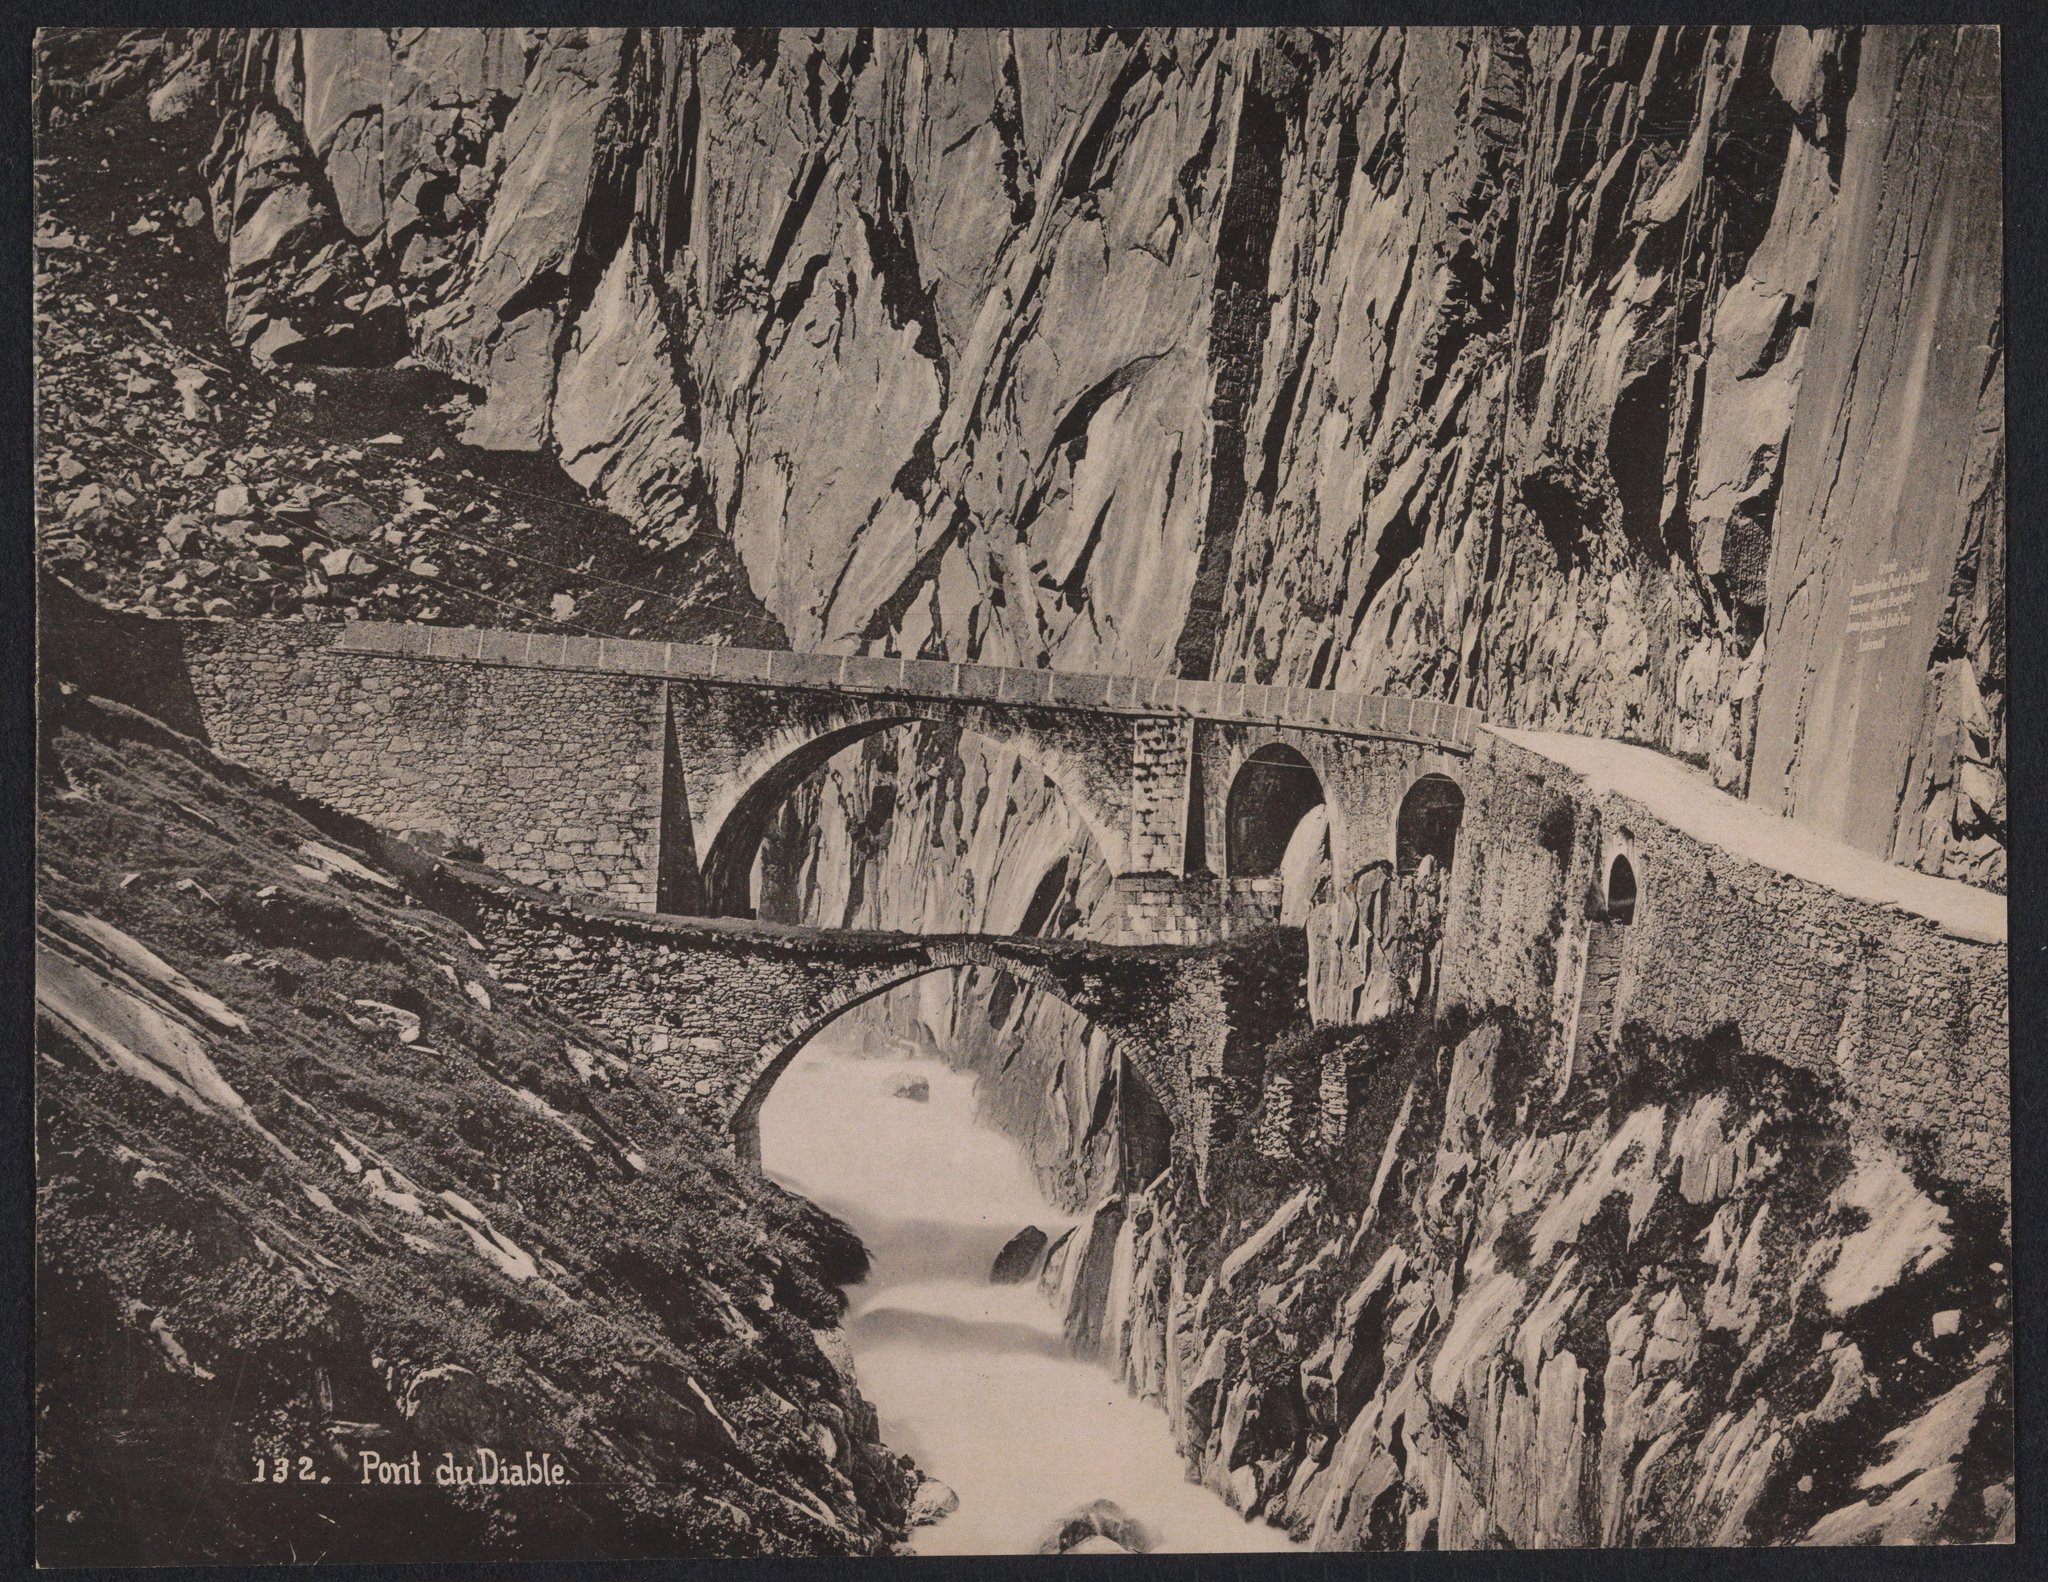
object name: photomechanical print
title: Gezicht op de Teufelsbrücke over de Schöllenenkloof nabij de Gotthardpas, Zwitserland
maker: Anonymous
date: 1880-1985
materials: cardboard, paper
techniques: photograph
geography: schöllenenkloof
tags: ravine, chasm, abyss, canyon, brook, bridge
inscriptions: number: ‘132’